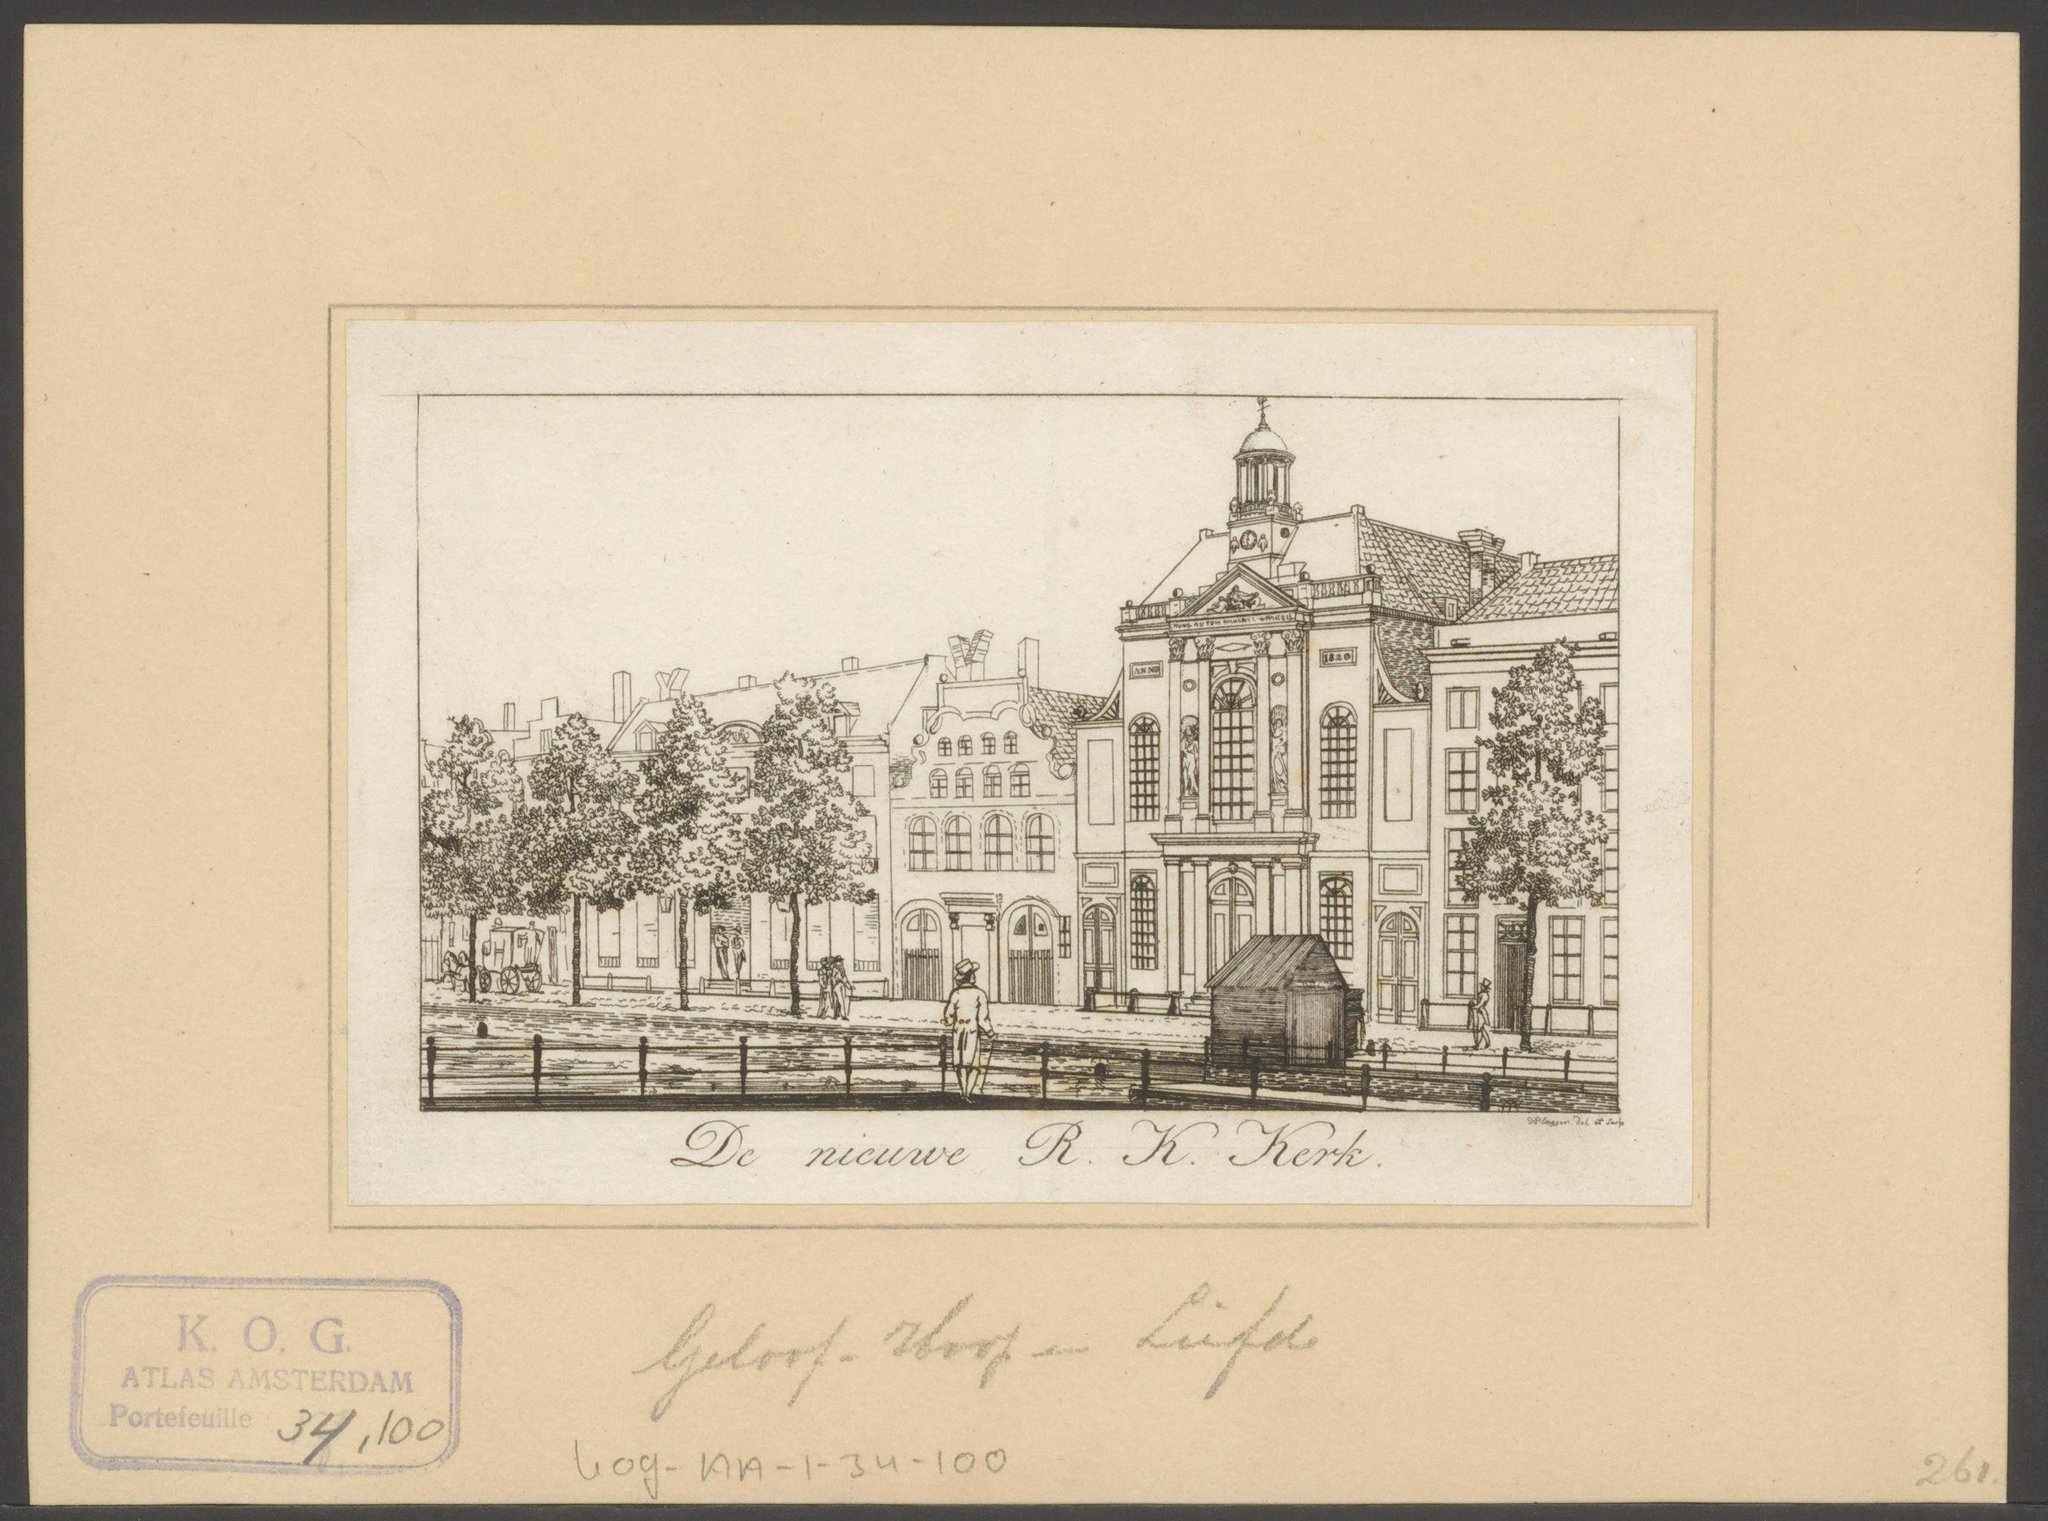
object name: print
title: Gezicht op de Sint-Catharinakerk te Amsterdam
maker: jacob plügger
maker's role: print maker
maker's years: 1795-1871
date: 1845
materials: paper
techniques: etching, letterpress printing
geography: netherlands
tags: church (exterior), canals, waters (in city) (+ city(-scape) with figures, staffage)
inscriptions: collector's mark: Lugt 1641b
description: Prent uit een onbekende publicatie. Andere staat van prent (met onderschrift in het Frans) ook gebruikt in: Olivier, William John. Nouveau tableau statistique, historique, d'Amsterdam (...). Amsterdam: Johannes Guykens, [ca. 1845].